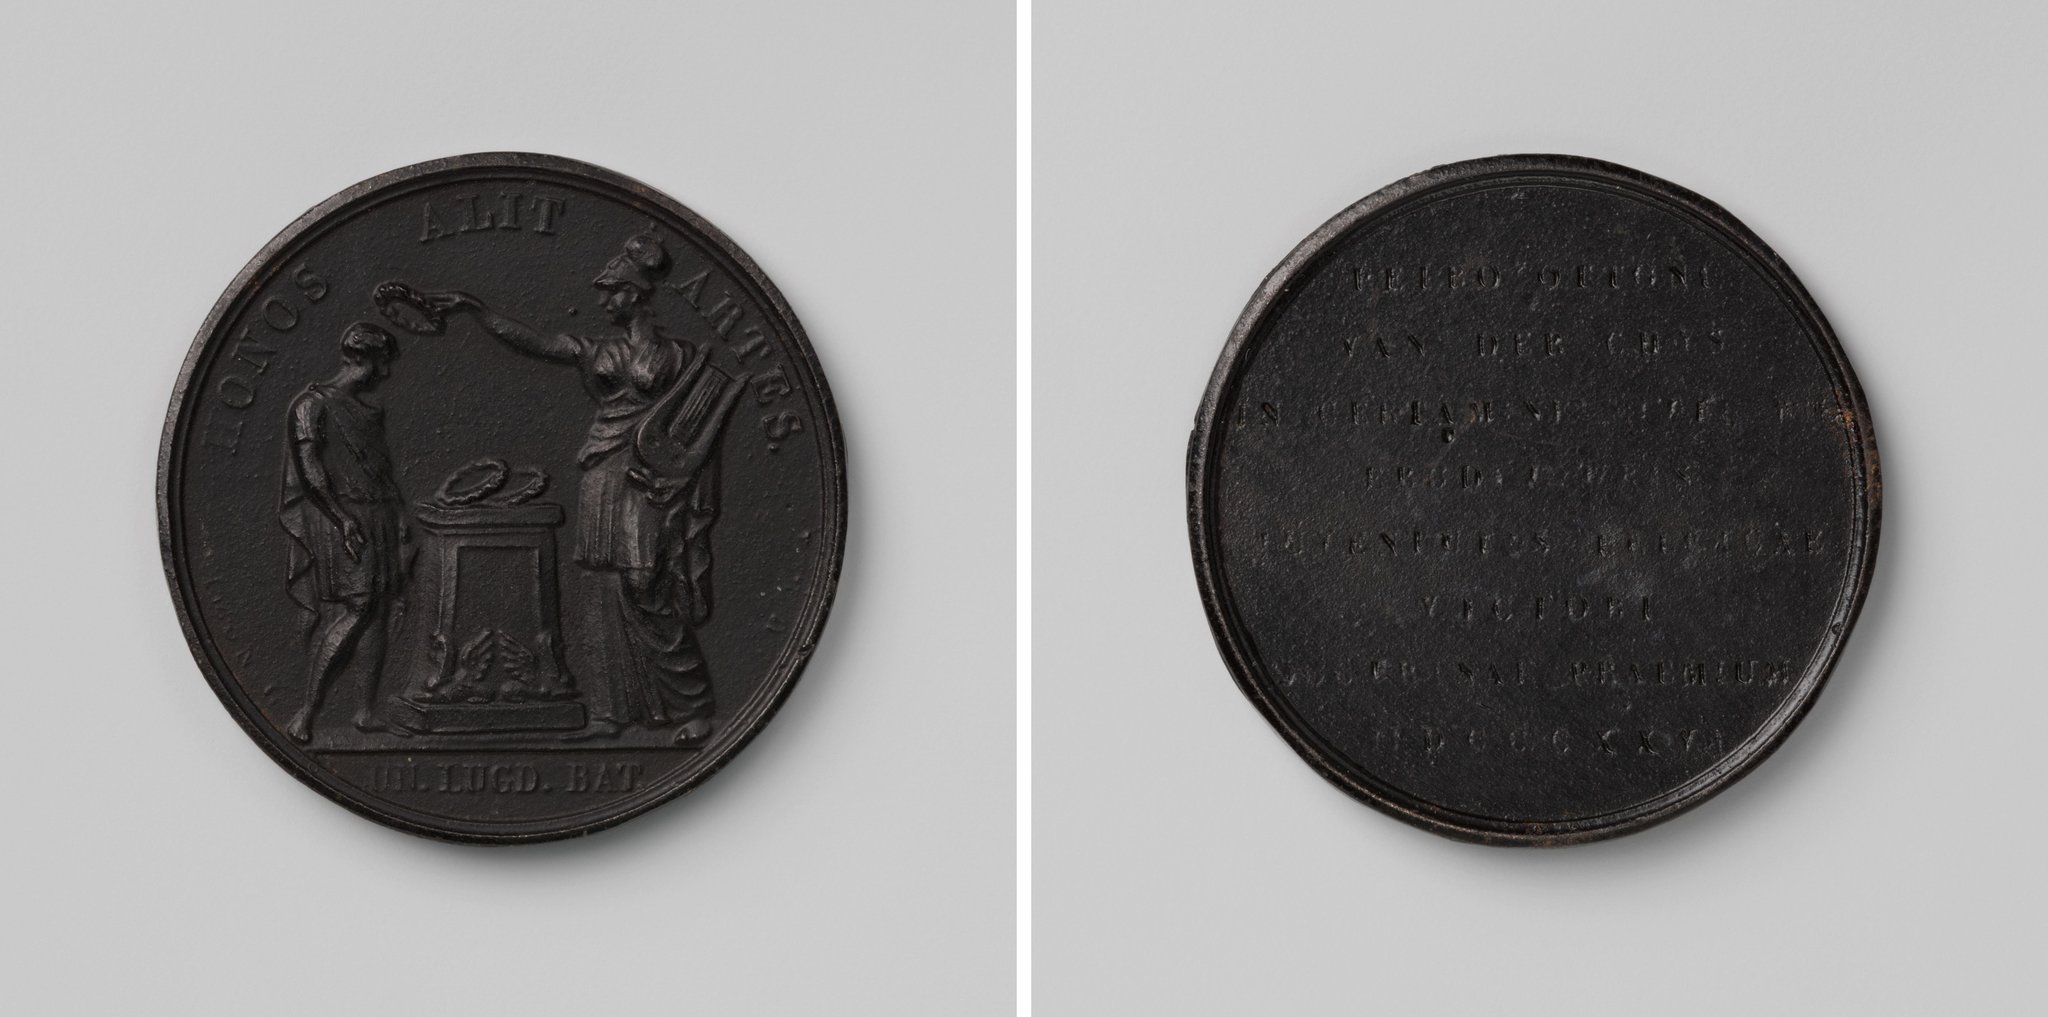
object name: medal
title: Universiteit van Leiden, penning uitgereikt aan Pieter Otto van der Chijs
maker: jean henri simon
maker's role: medailleur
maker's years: 1752-1834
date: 1826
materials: iron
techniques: casting, engraving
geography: brussels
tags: pieter otto van der chijs, leiden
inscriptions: inscription: ‘HONOS ALIT ARTES. / UN.LUGD.BAT’, inscription: ‘PETRO OTTONI / VAN DER CHYS / IN CERTAM / ...D... / ...D BELGICAE / VICTORI / DOCTRINAE PRAEMIUM / MDCCCXXVI’